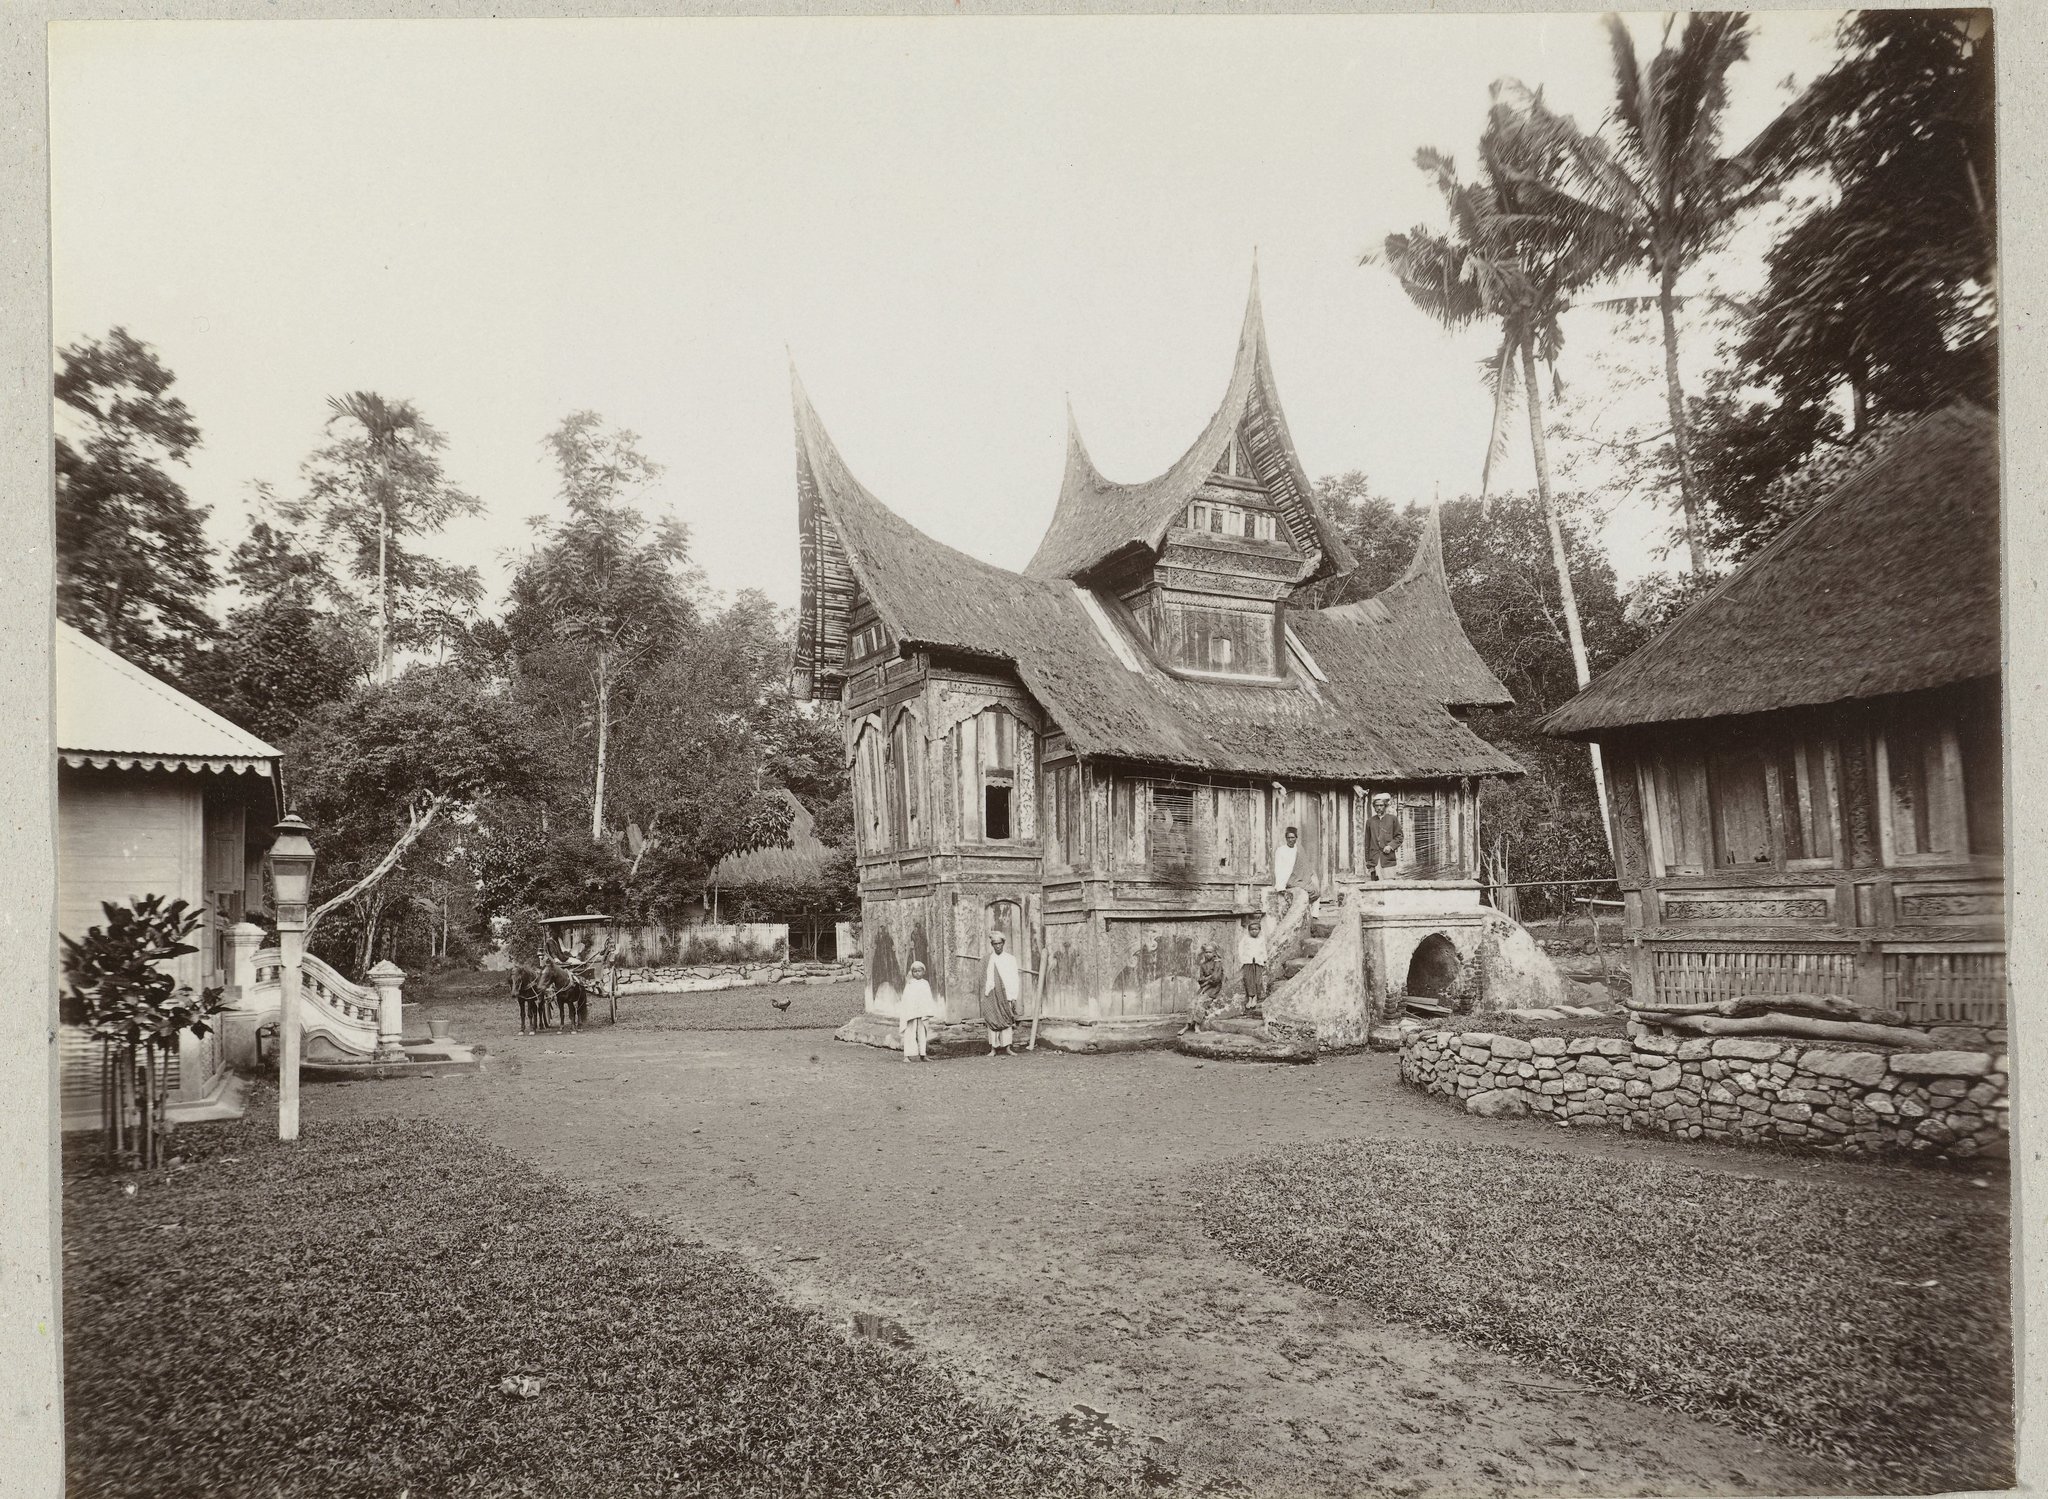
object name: photograph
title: Gezicht op een Minangkabauer woning in Bukittinggi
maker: christiaan benjamin nieuwenhuis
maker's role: publisher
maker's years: 1863-1922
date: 1891-1912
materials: paper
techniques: albumen print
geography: bukittinggi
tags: village (+ city(-scape) with figures, staffage)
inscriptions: inscription: ‘Pad. Bovenl huis/ Fort de Kock’